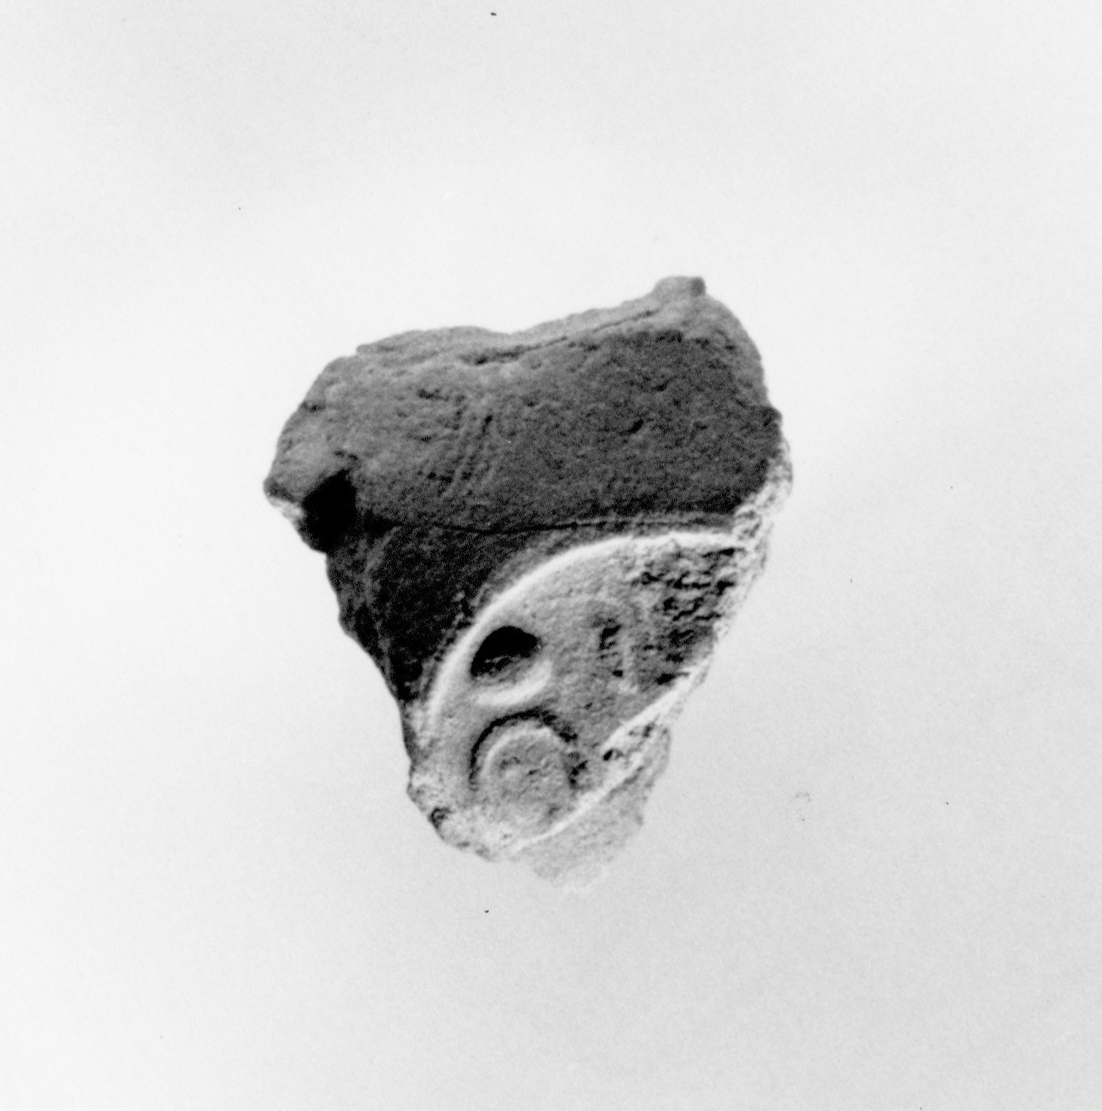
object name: sealing, nebmaatre, amenhotep iii,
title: Document Sealing With the Throne Name of Amenhotep III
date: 1390-1352 BCE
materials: mud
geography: egypt